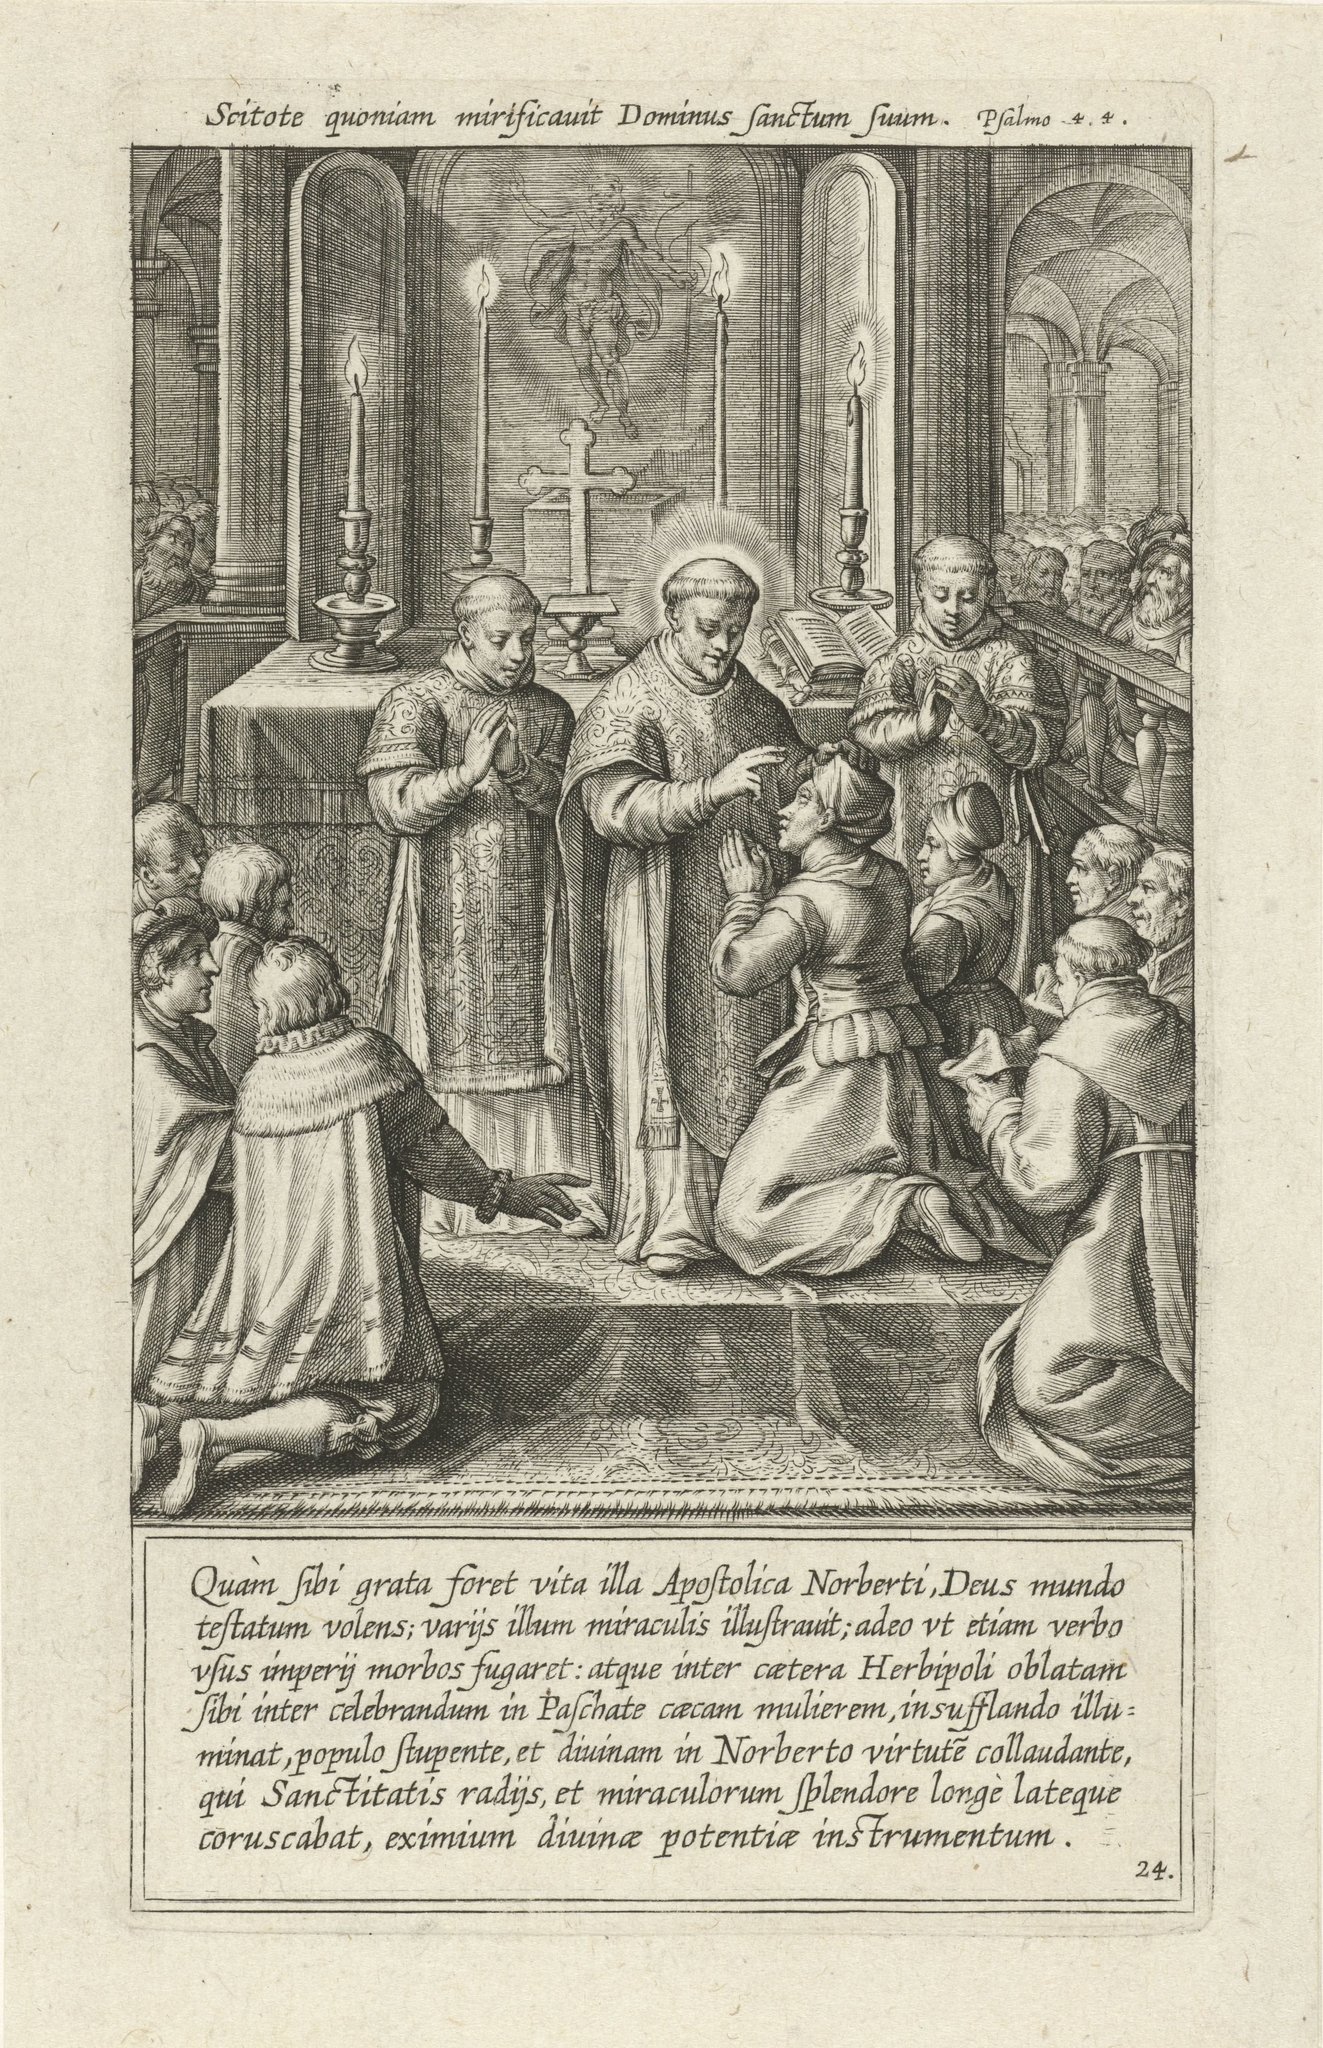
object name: print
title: Wijding van vrouwelijke kloosterlingen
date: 1622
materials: paper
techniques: engraving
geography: antwerp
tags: non-miraculous activities and events ~ st. norbert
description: In een kerk wijdt de heilige Norbertus de eerste vrouwelijke kloosterlingen (Norbertinessen). De prent heeft twee Latijnse opschriften: een boven en een onder de voorstelling.